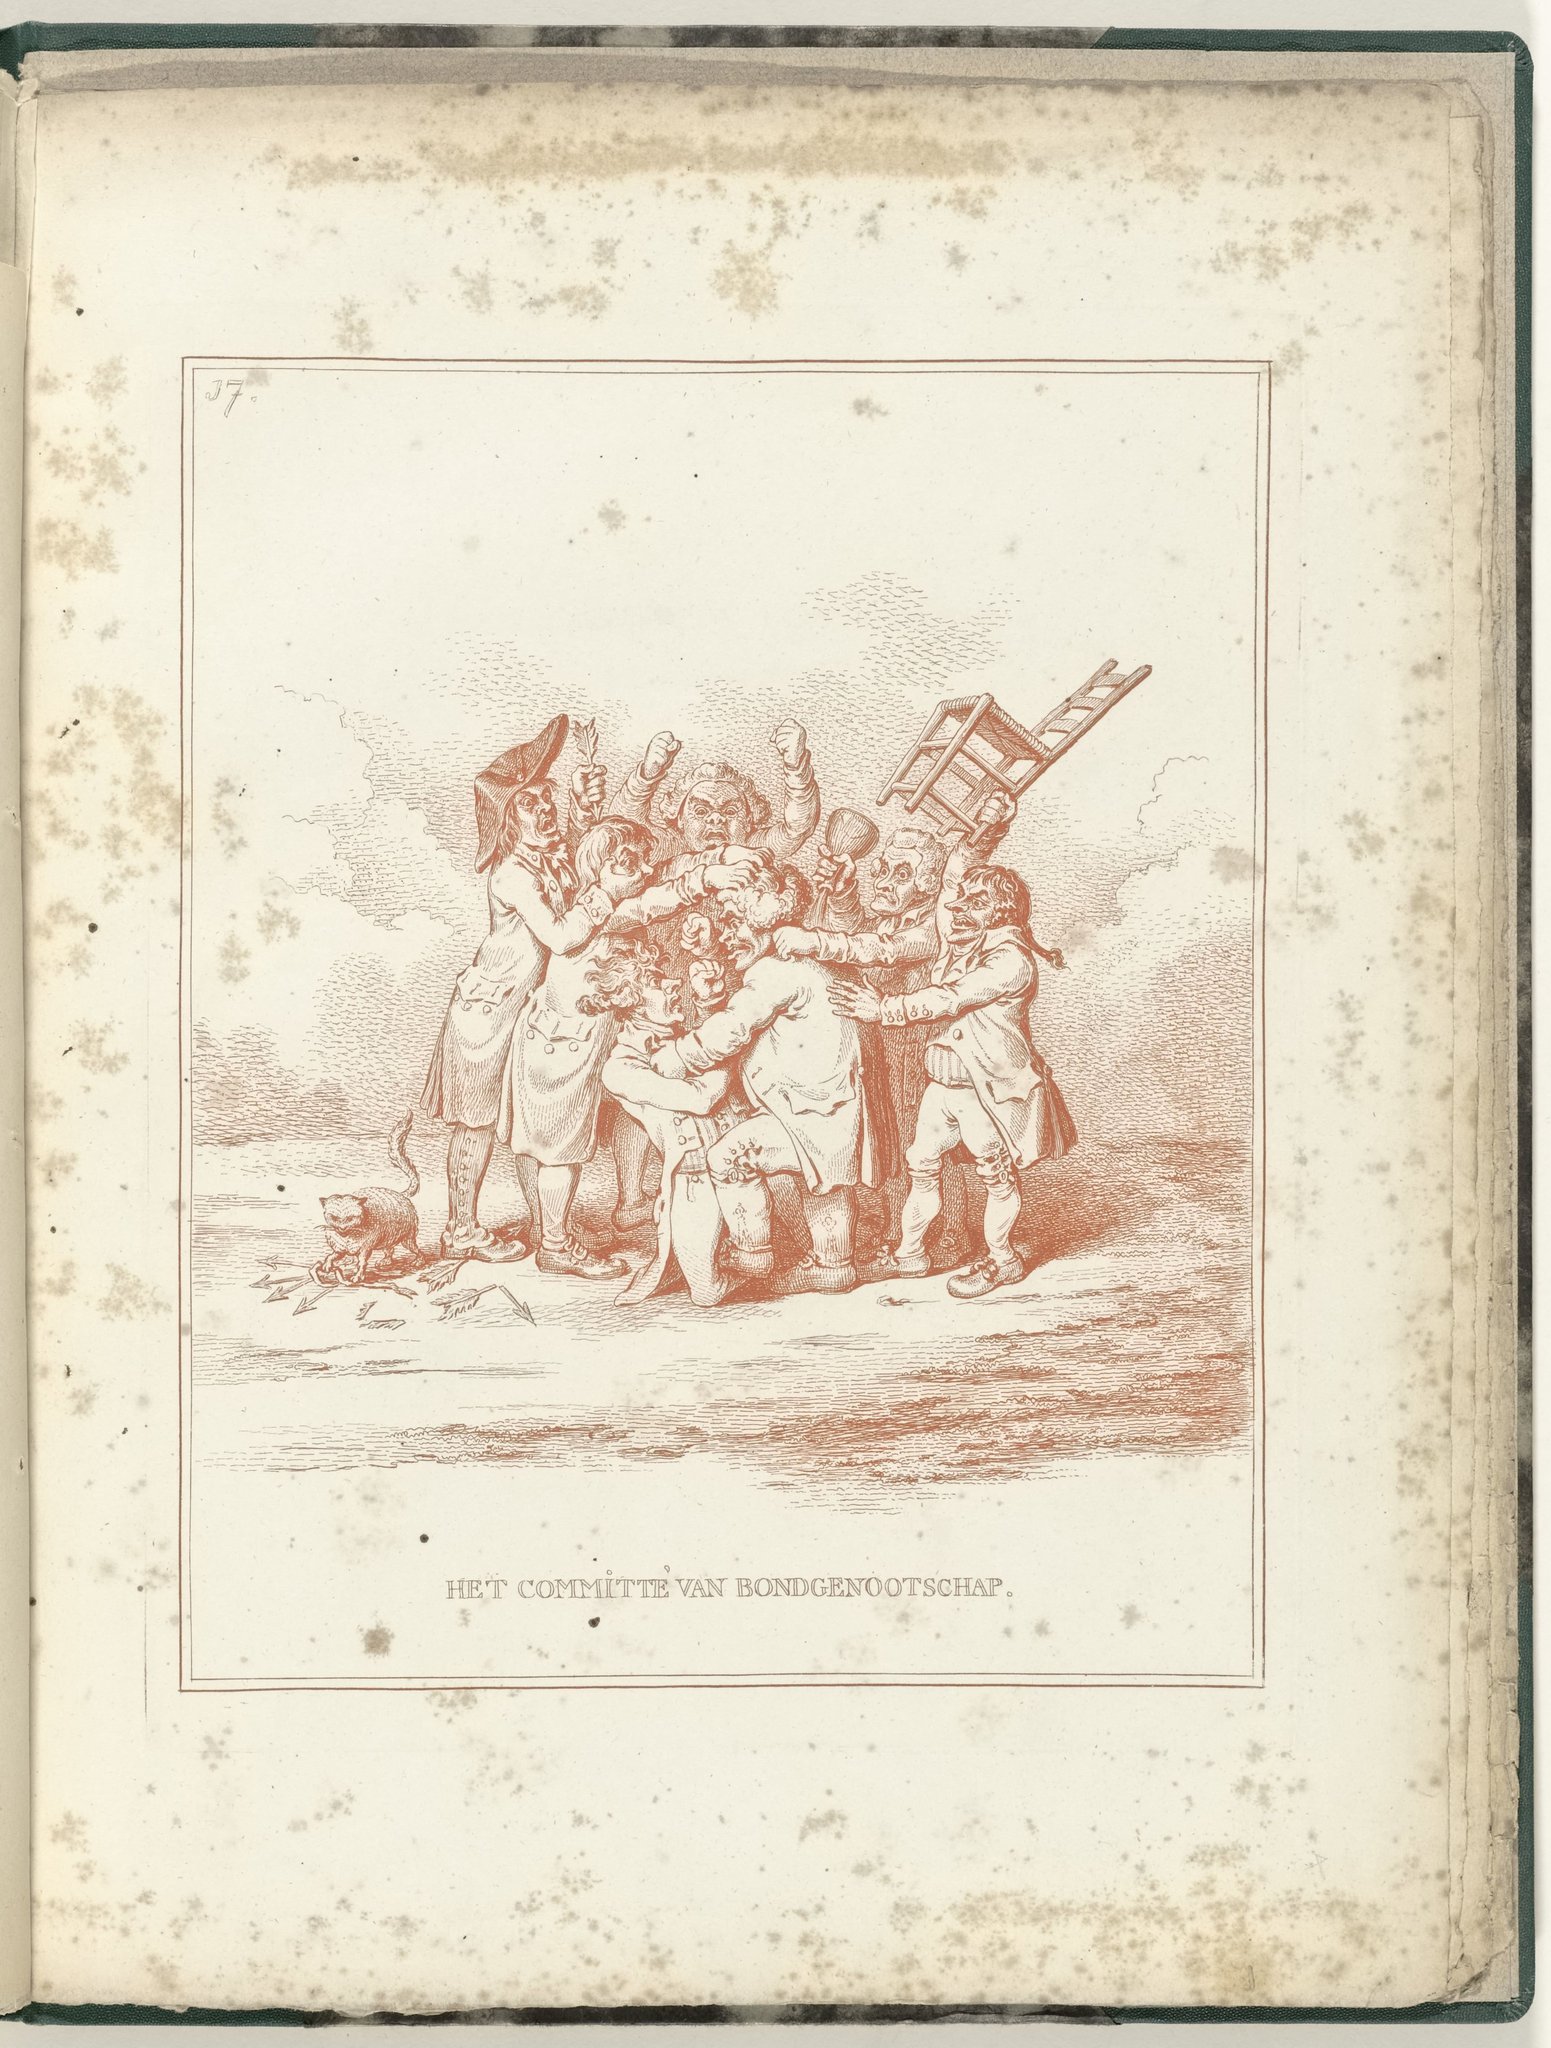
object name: print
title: Het Committé van Bondgenootschap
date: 1795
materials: paper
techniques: etching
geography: london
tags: fighting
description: Onderdeel van een in boekvorm uitgegeven serie van twintig spotprenten op de Provisionele Representanten van het Volk van Holland en de Bataafse Republiek in het algemeen in het jaar 1795. De serietitel 'Hollandia Regenerata' staat vermeld op de titelprent. Elke prent gevolgd door een tekstblad met een Bijbelcitaat in het Nederlands, een verklaring in het Frans en het Bijbelcitaat in het Engels. Waarschijnlijk uitgegeven in Londen door William Humphrey in 1795.